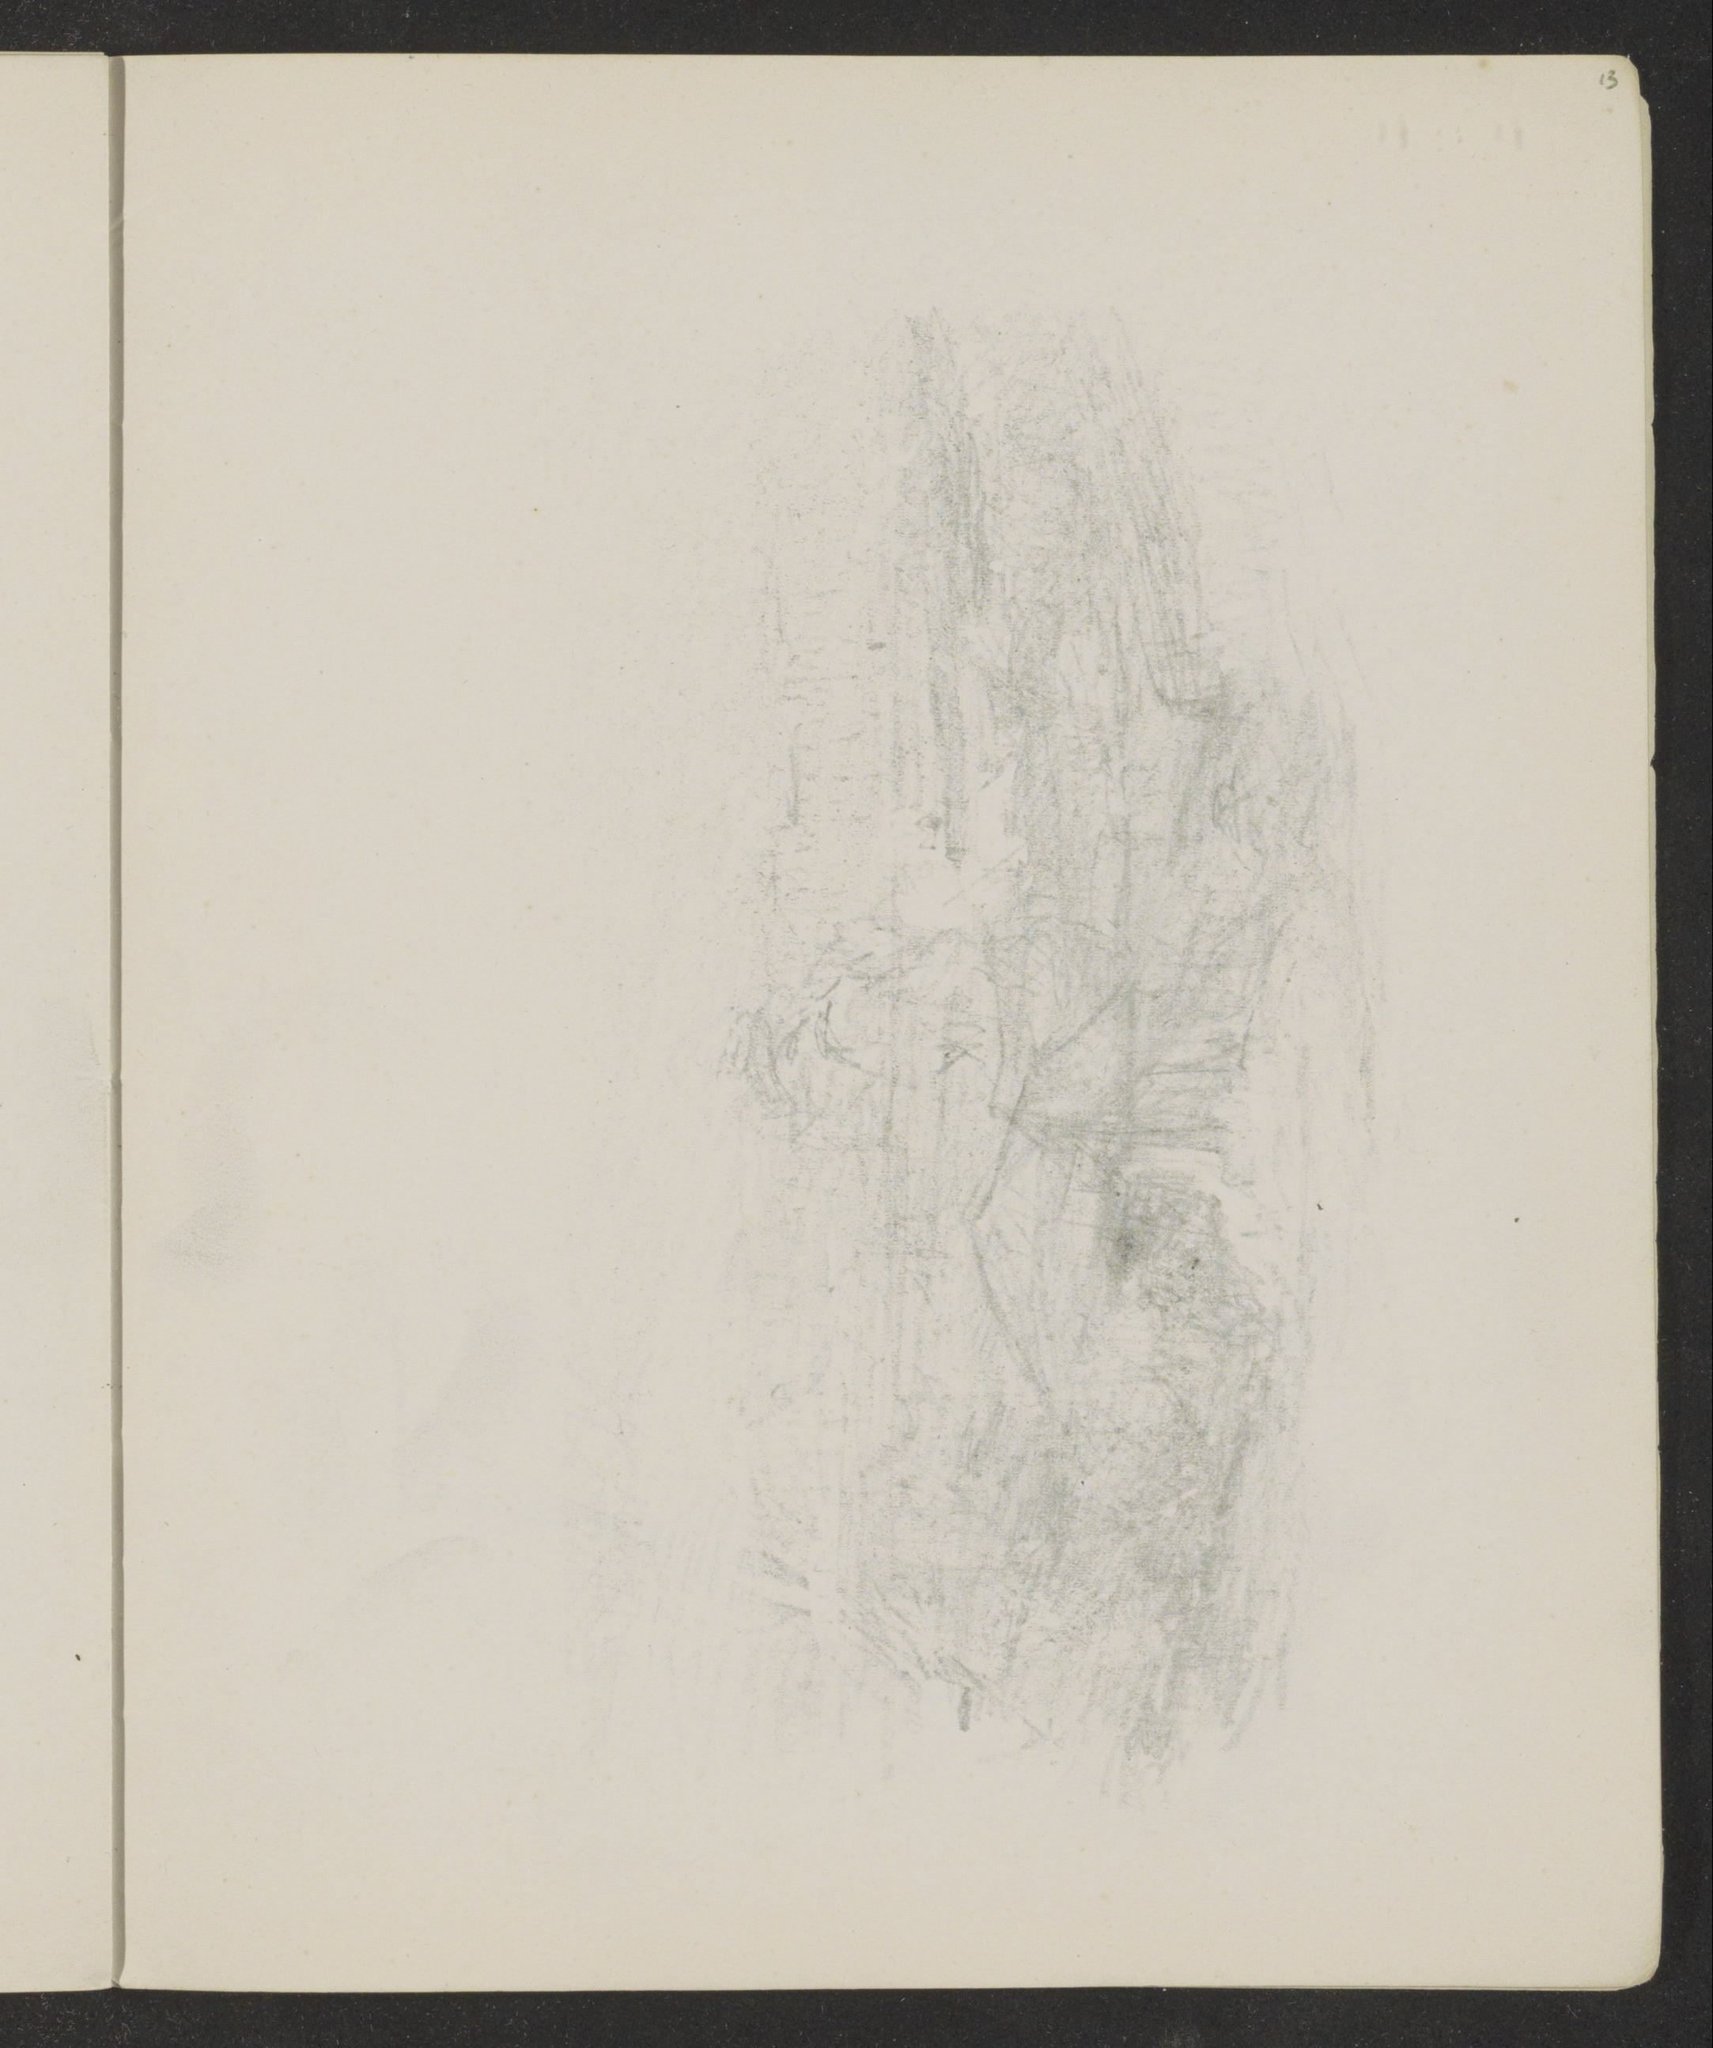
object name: sketchbook leaf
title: Abklatsch en doordruk van de tekeningen op pagina 12 en 13 verso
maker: maria vos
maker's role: draughtsman, painter, print maker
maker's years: 1824-1906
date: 1886-1890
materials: paper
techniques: printmaking, transfer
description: Blad 13 recto uit een schetsboek met 17 bladen.